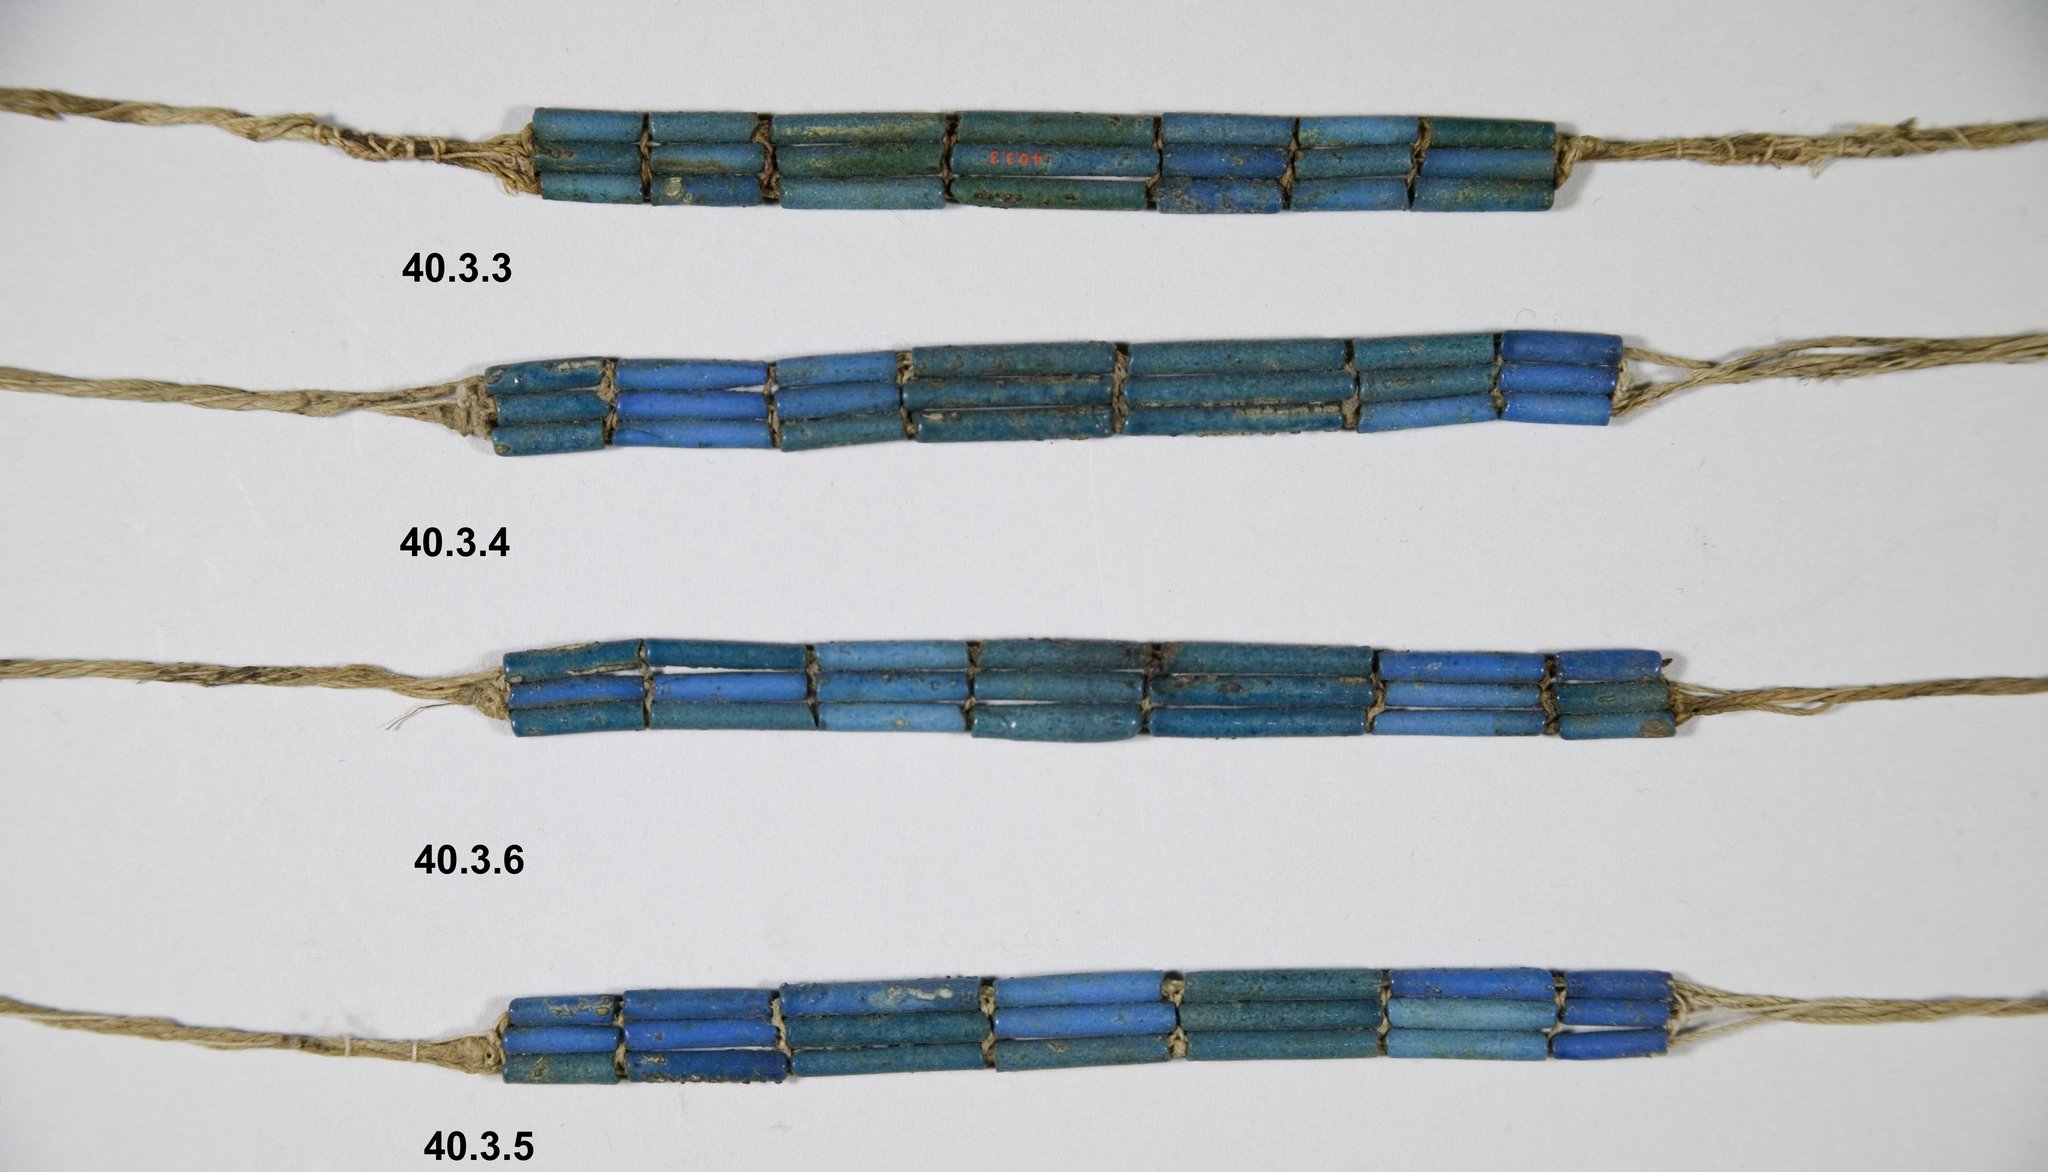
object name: bracelet, wah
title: Bracelet of Wah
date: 1981-1975 BCE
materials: faience, linen, thread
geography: egypt